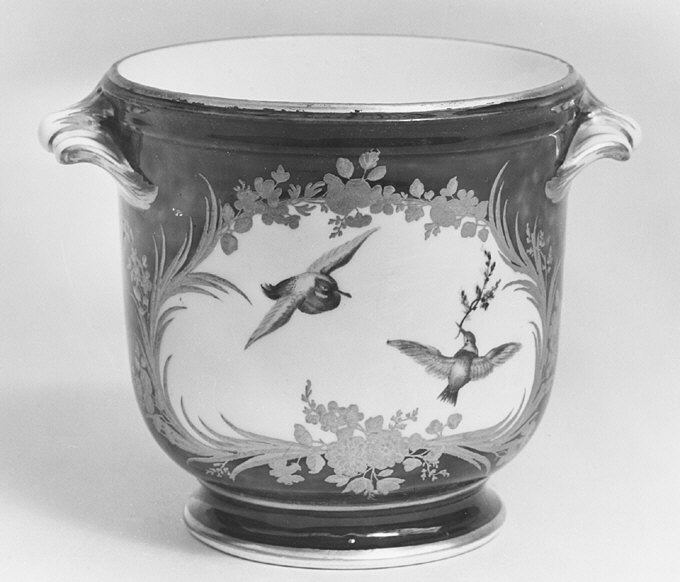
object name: wine cooler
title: Wine glass cooler (seau à verre)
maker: vincennes manufactory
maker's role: manufactory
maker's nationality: french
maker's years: 1740-1756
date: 1754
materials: soft paste porcelain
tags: birds,flowers